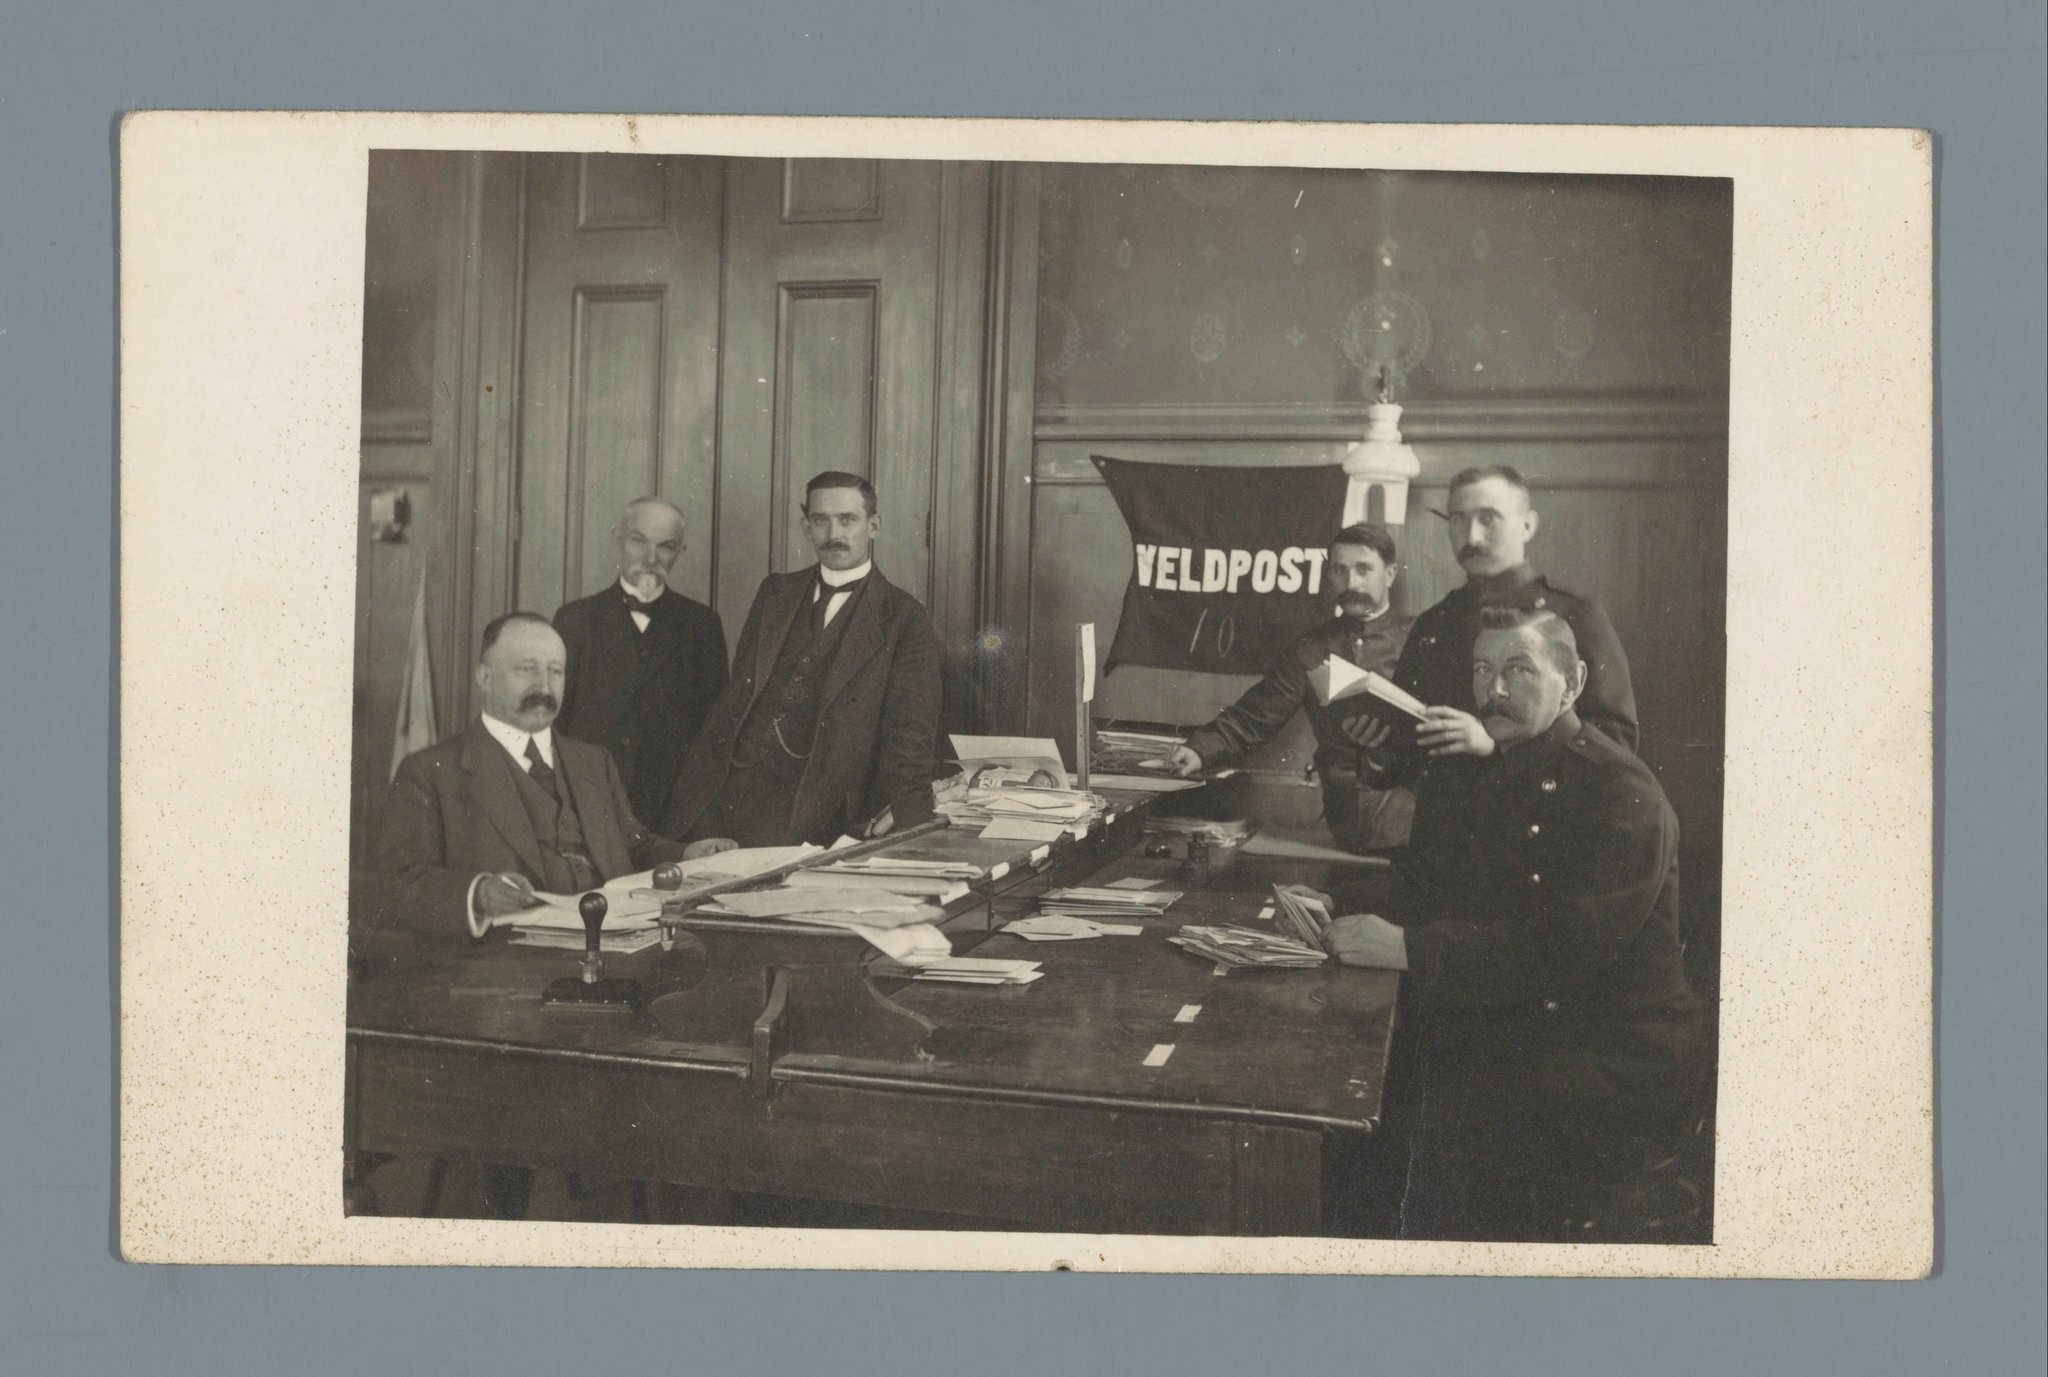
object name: ansichtkaart, prentbriefkaart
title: Portret van (vermoedelijk) zes medewerkers van een veldpostkantoor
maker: Anonymous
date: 1915-1925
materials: photographic support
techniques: gelatin silver print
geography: netherlands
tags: post-office, interior ~ representation of a building, anonymous historical persons portrayed in a group, in a group-portrait